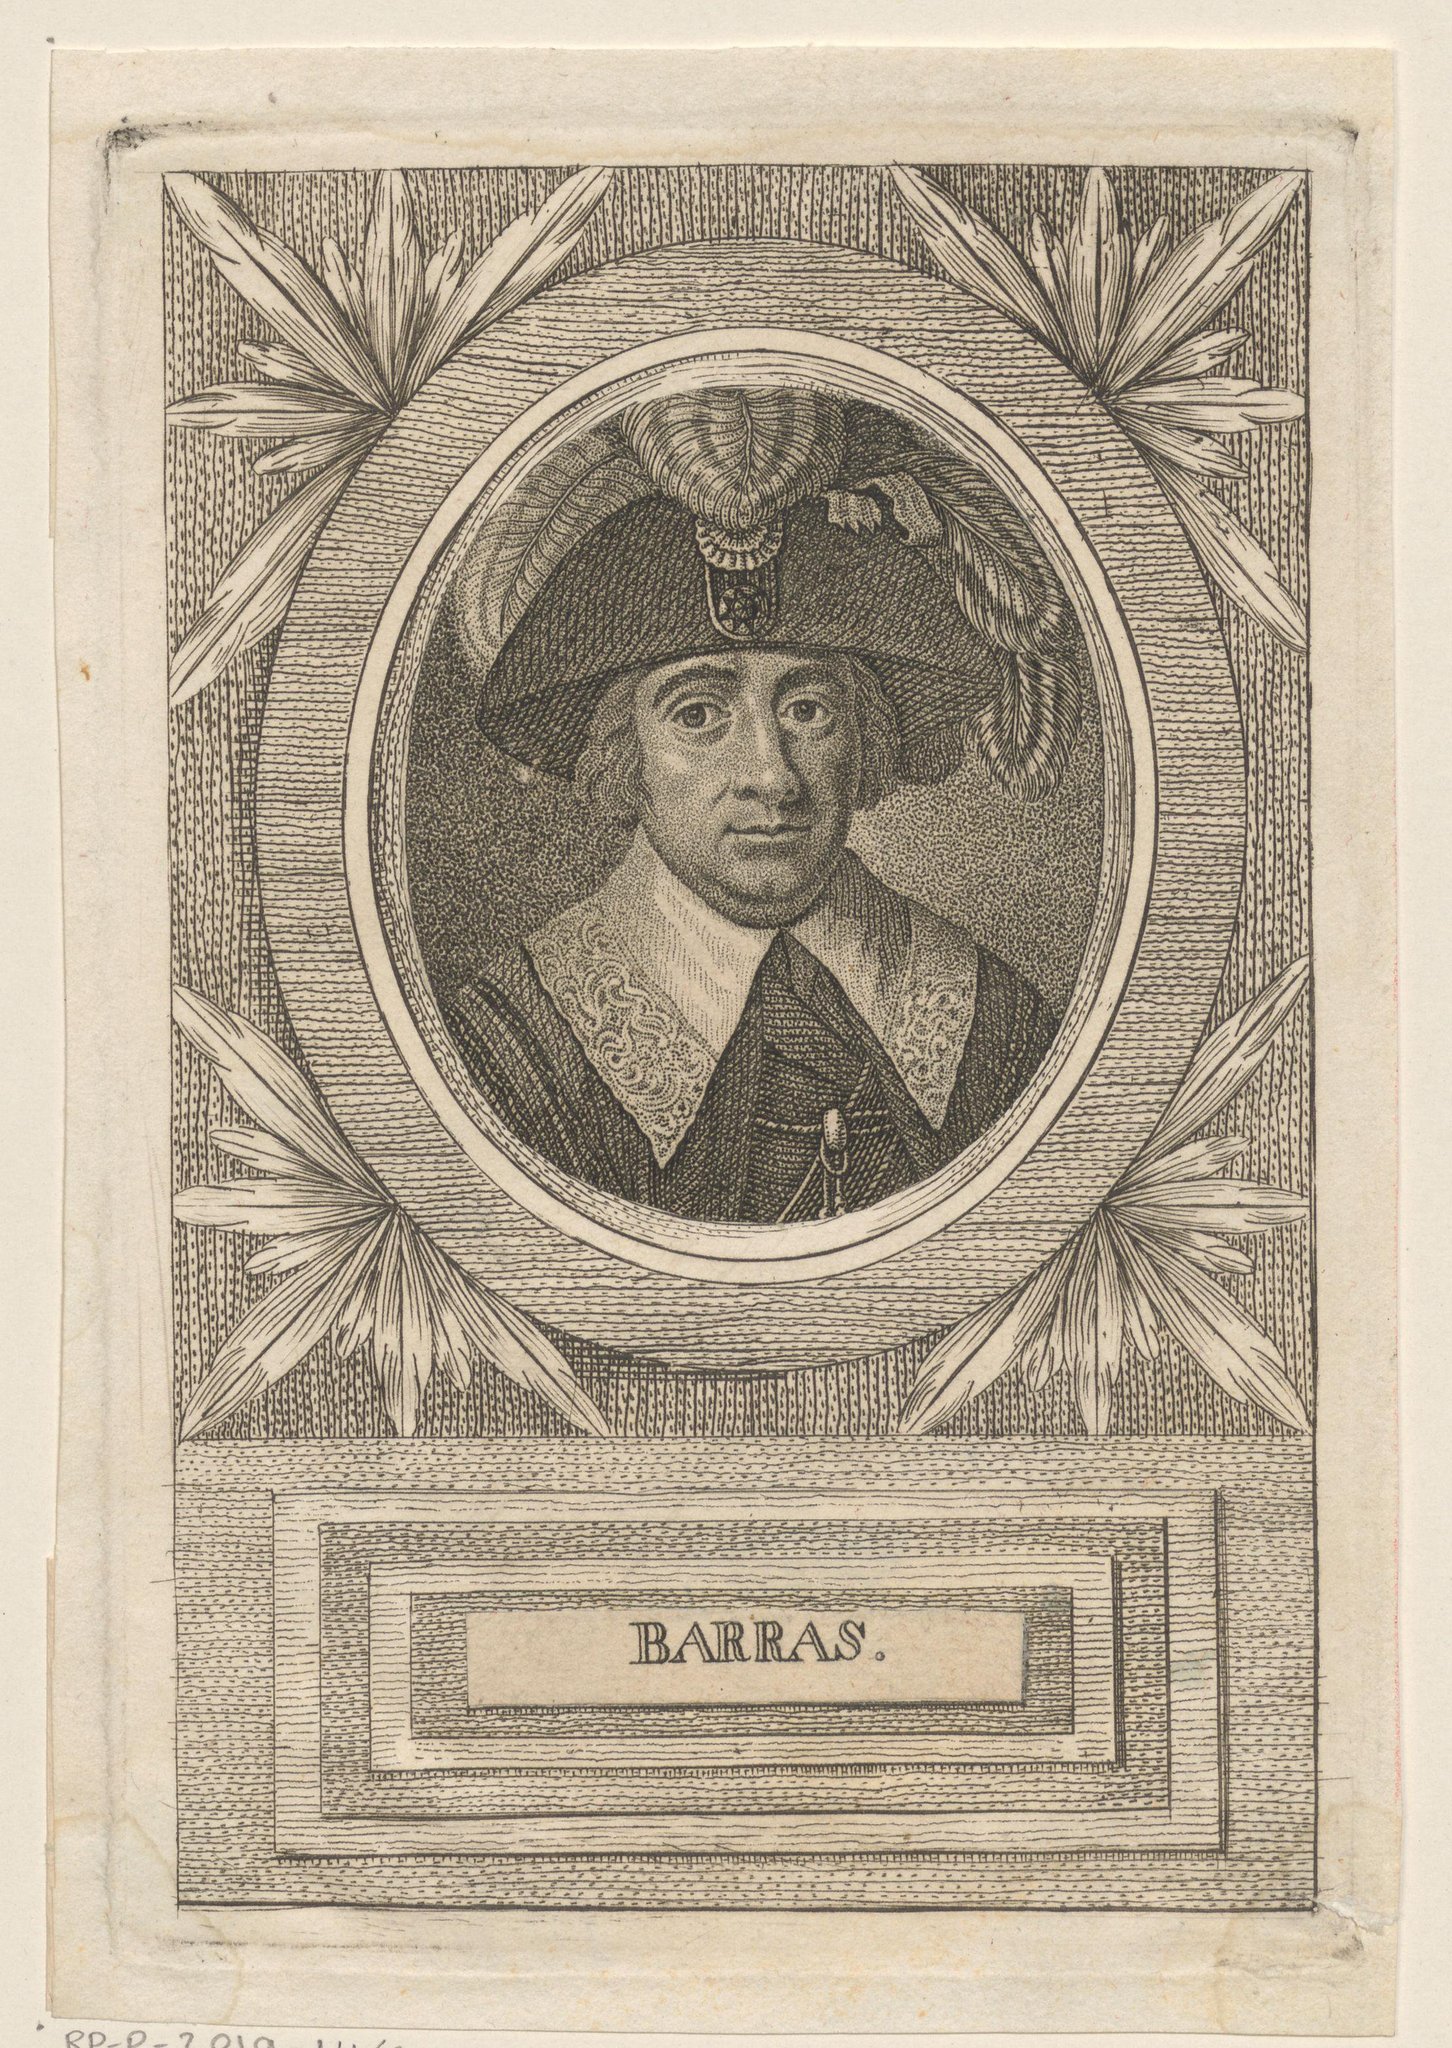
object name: print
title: Portret van Paul Barras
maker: Anonymous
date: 1790-1849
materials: paper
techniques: etching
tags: politician, historical persons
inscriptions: collector's mark: Lugt 2228